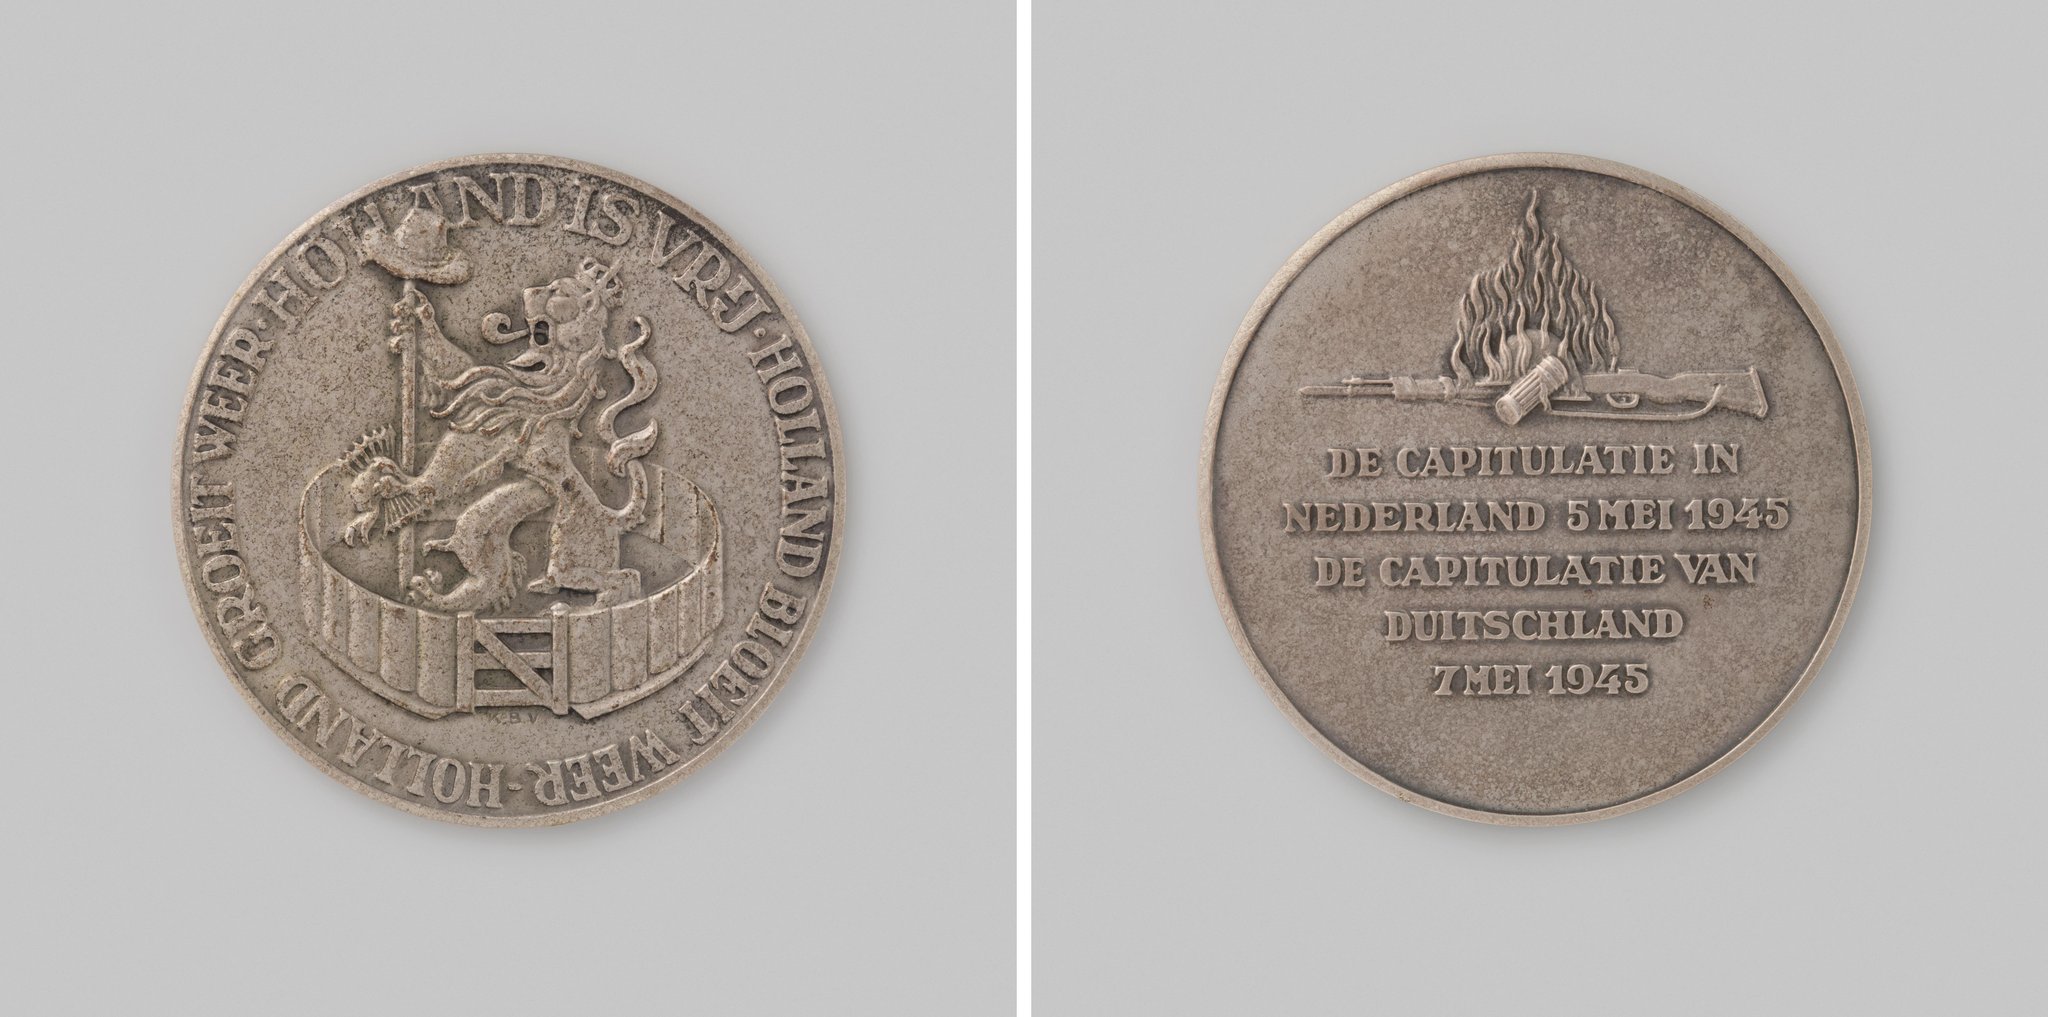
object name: medal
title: Bevrijding van Nederland en capitulatie van Duitsland, 1945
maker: j.ph. van zegveld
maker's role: medailleur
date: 1905-1945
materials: silver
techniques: striking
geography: netherlands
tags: netherlands, germany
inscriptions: inscription: ‘Holland is vrij. Holland bloeit weer. Holland groeit weer.’, inscription: ‘De capitulatie in / Nederland 5 mei 1945 / de capitulatie van / Duitschland / 7 mei 1945’, mark: ‘K.B.V.’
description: Zilveren penning, vz naar links gekeerde kllimmende (Nederlandse) leeuw die in poten stok met vrijheidshoed vasthoudt binnen omheining met aan voorzijde een hekje (de 'Hollandse tuin'), met randschrift; kz liggend geweer, gasmasker en helm met vlammen erboven, waaronder in 5 regels tekst.